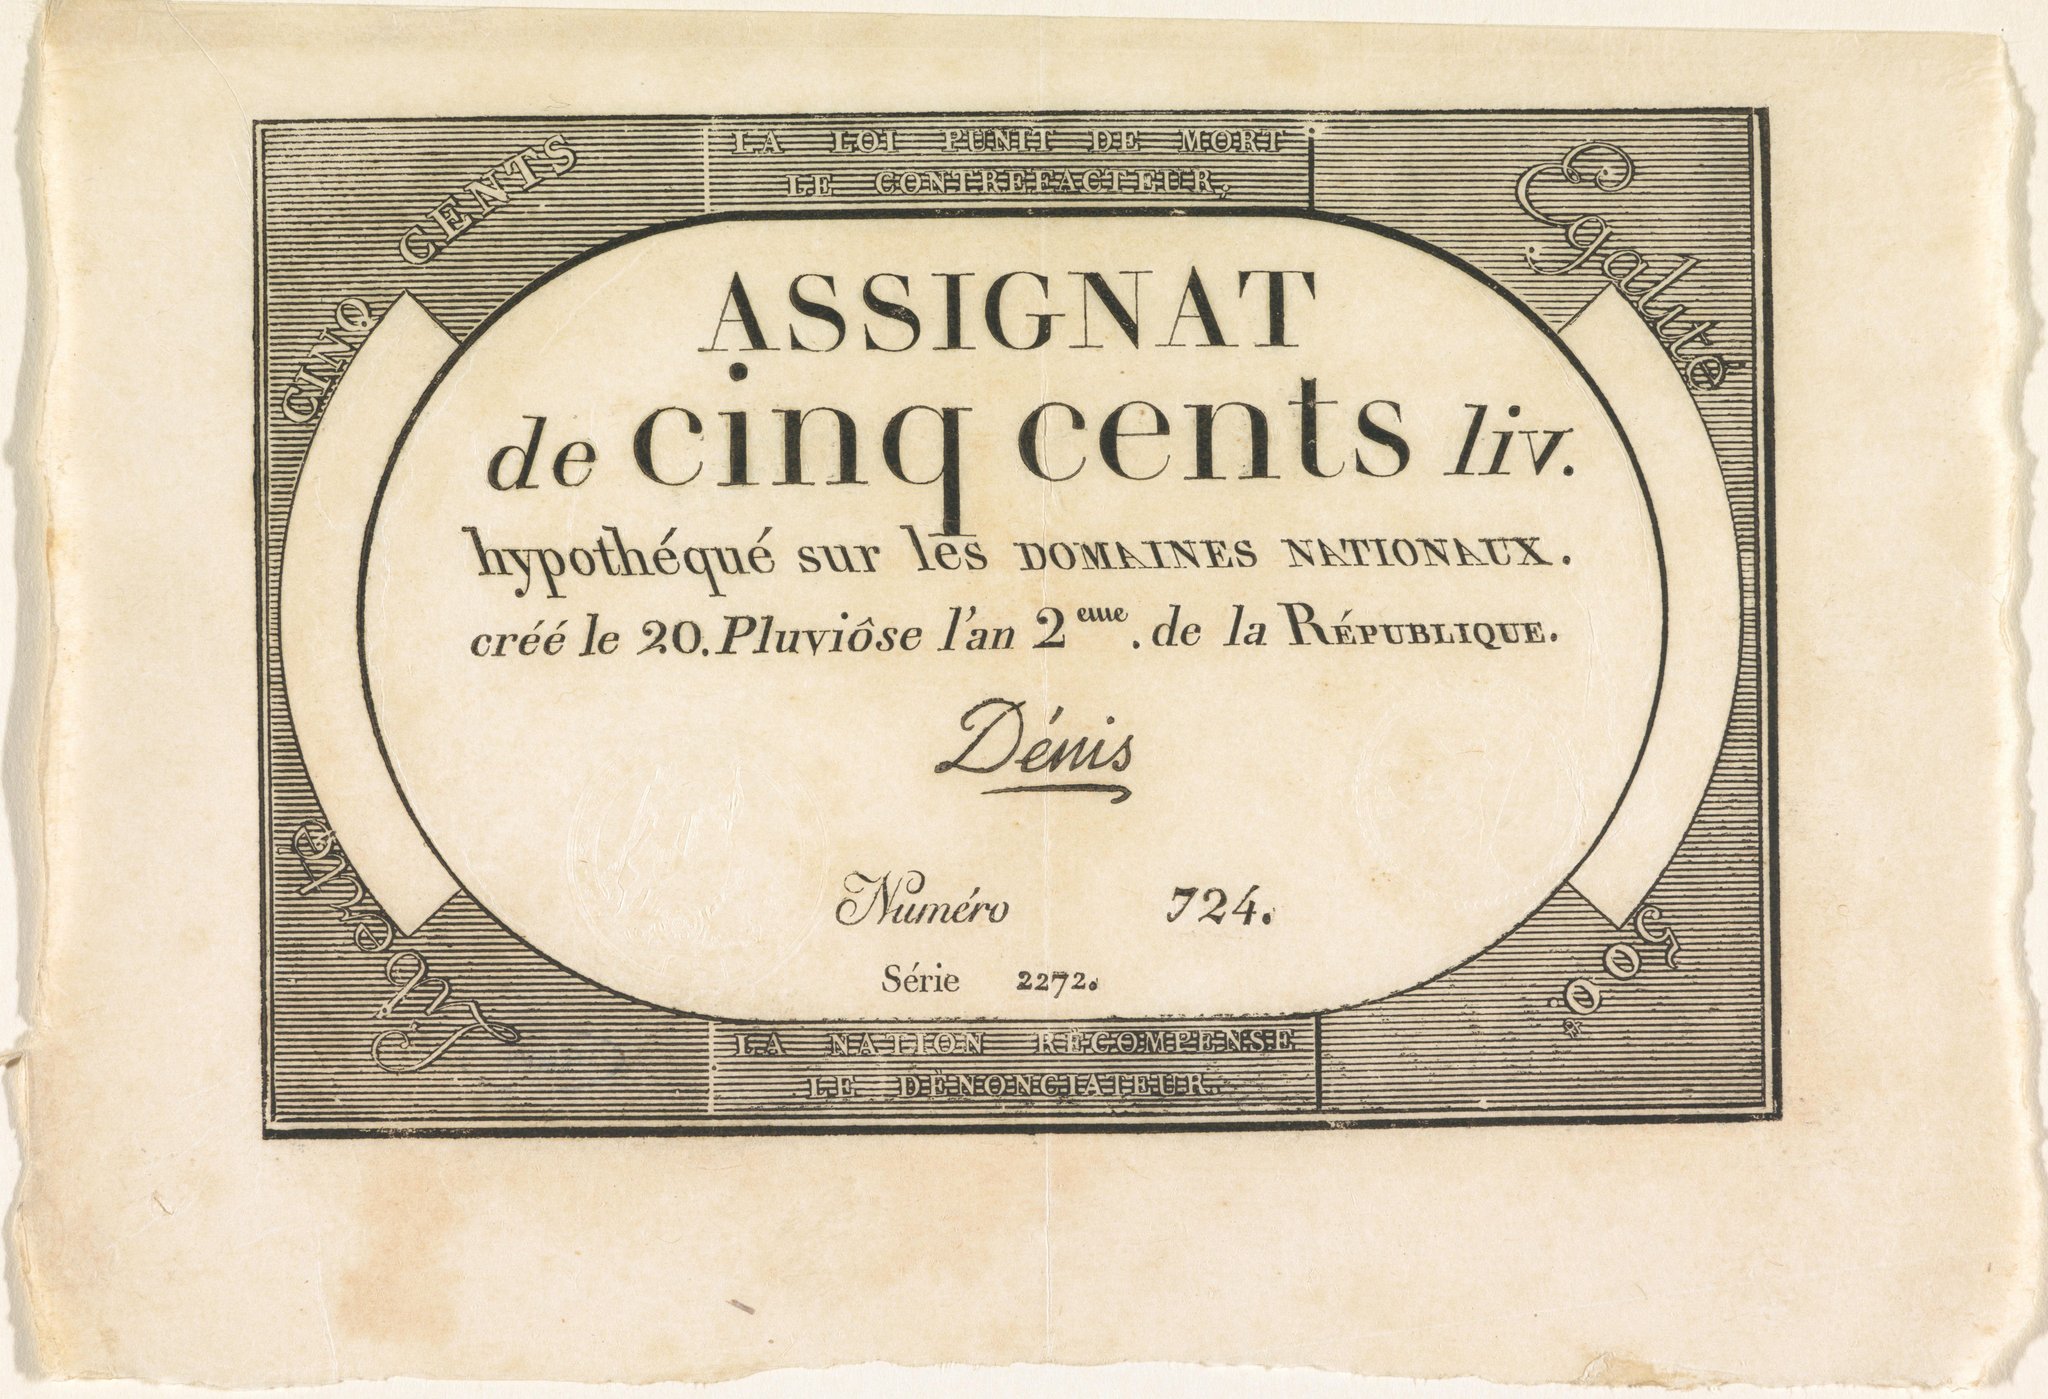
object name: assignat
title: Assignaat van 500 livres, 1793-1794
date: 1793-1794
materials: paper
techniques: blind stamped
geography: france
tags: bank-note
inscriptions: collector's mark: Lugt 2228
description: Assignaat van 500 livres. In omloop gebracht door de Domaines nationaux, serie 2272, 1793-1794.